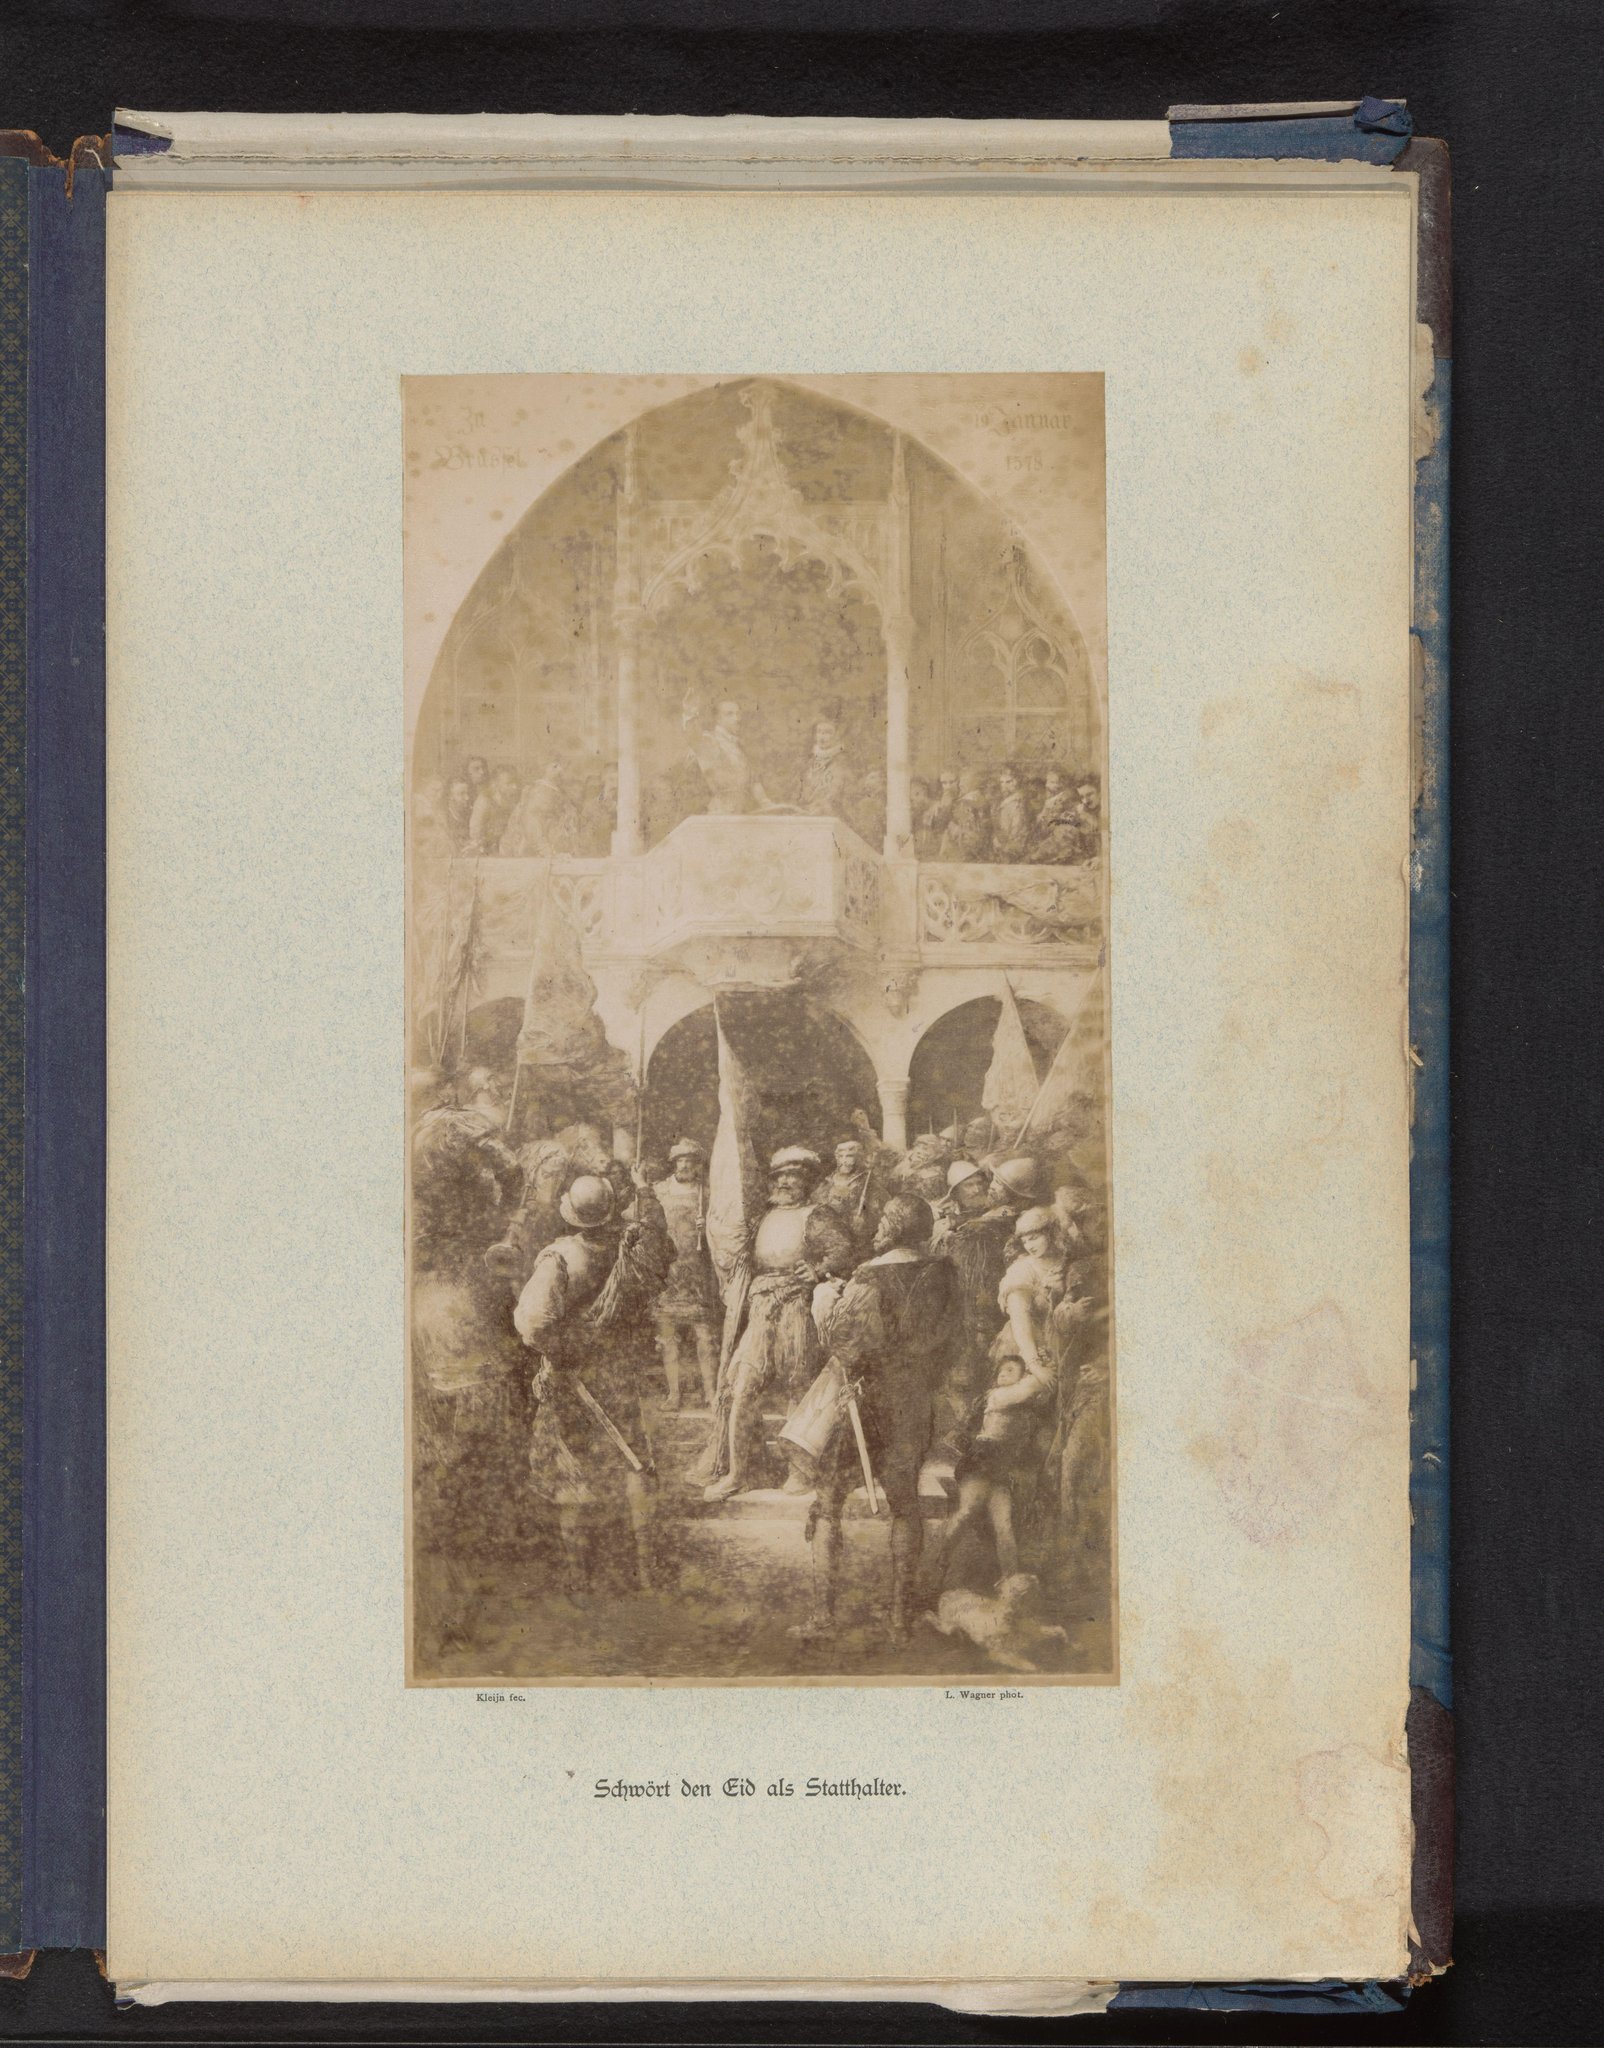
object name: photograph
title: Schwört den Eid als Statthalter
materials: photographic support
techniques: albumen print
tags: delft, william i (prince of orange), new ruler taking the oath, brussels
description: Deze foto maakt deel uit van een omslag met acht foto's op acht bladen en twee tekstbladen.